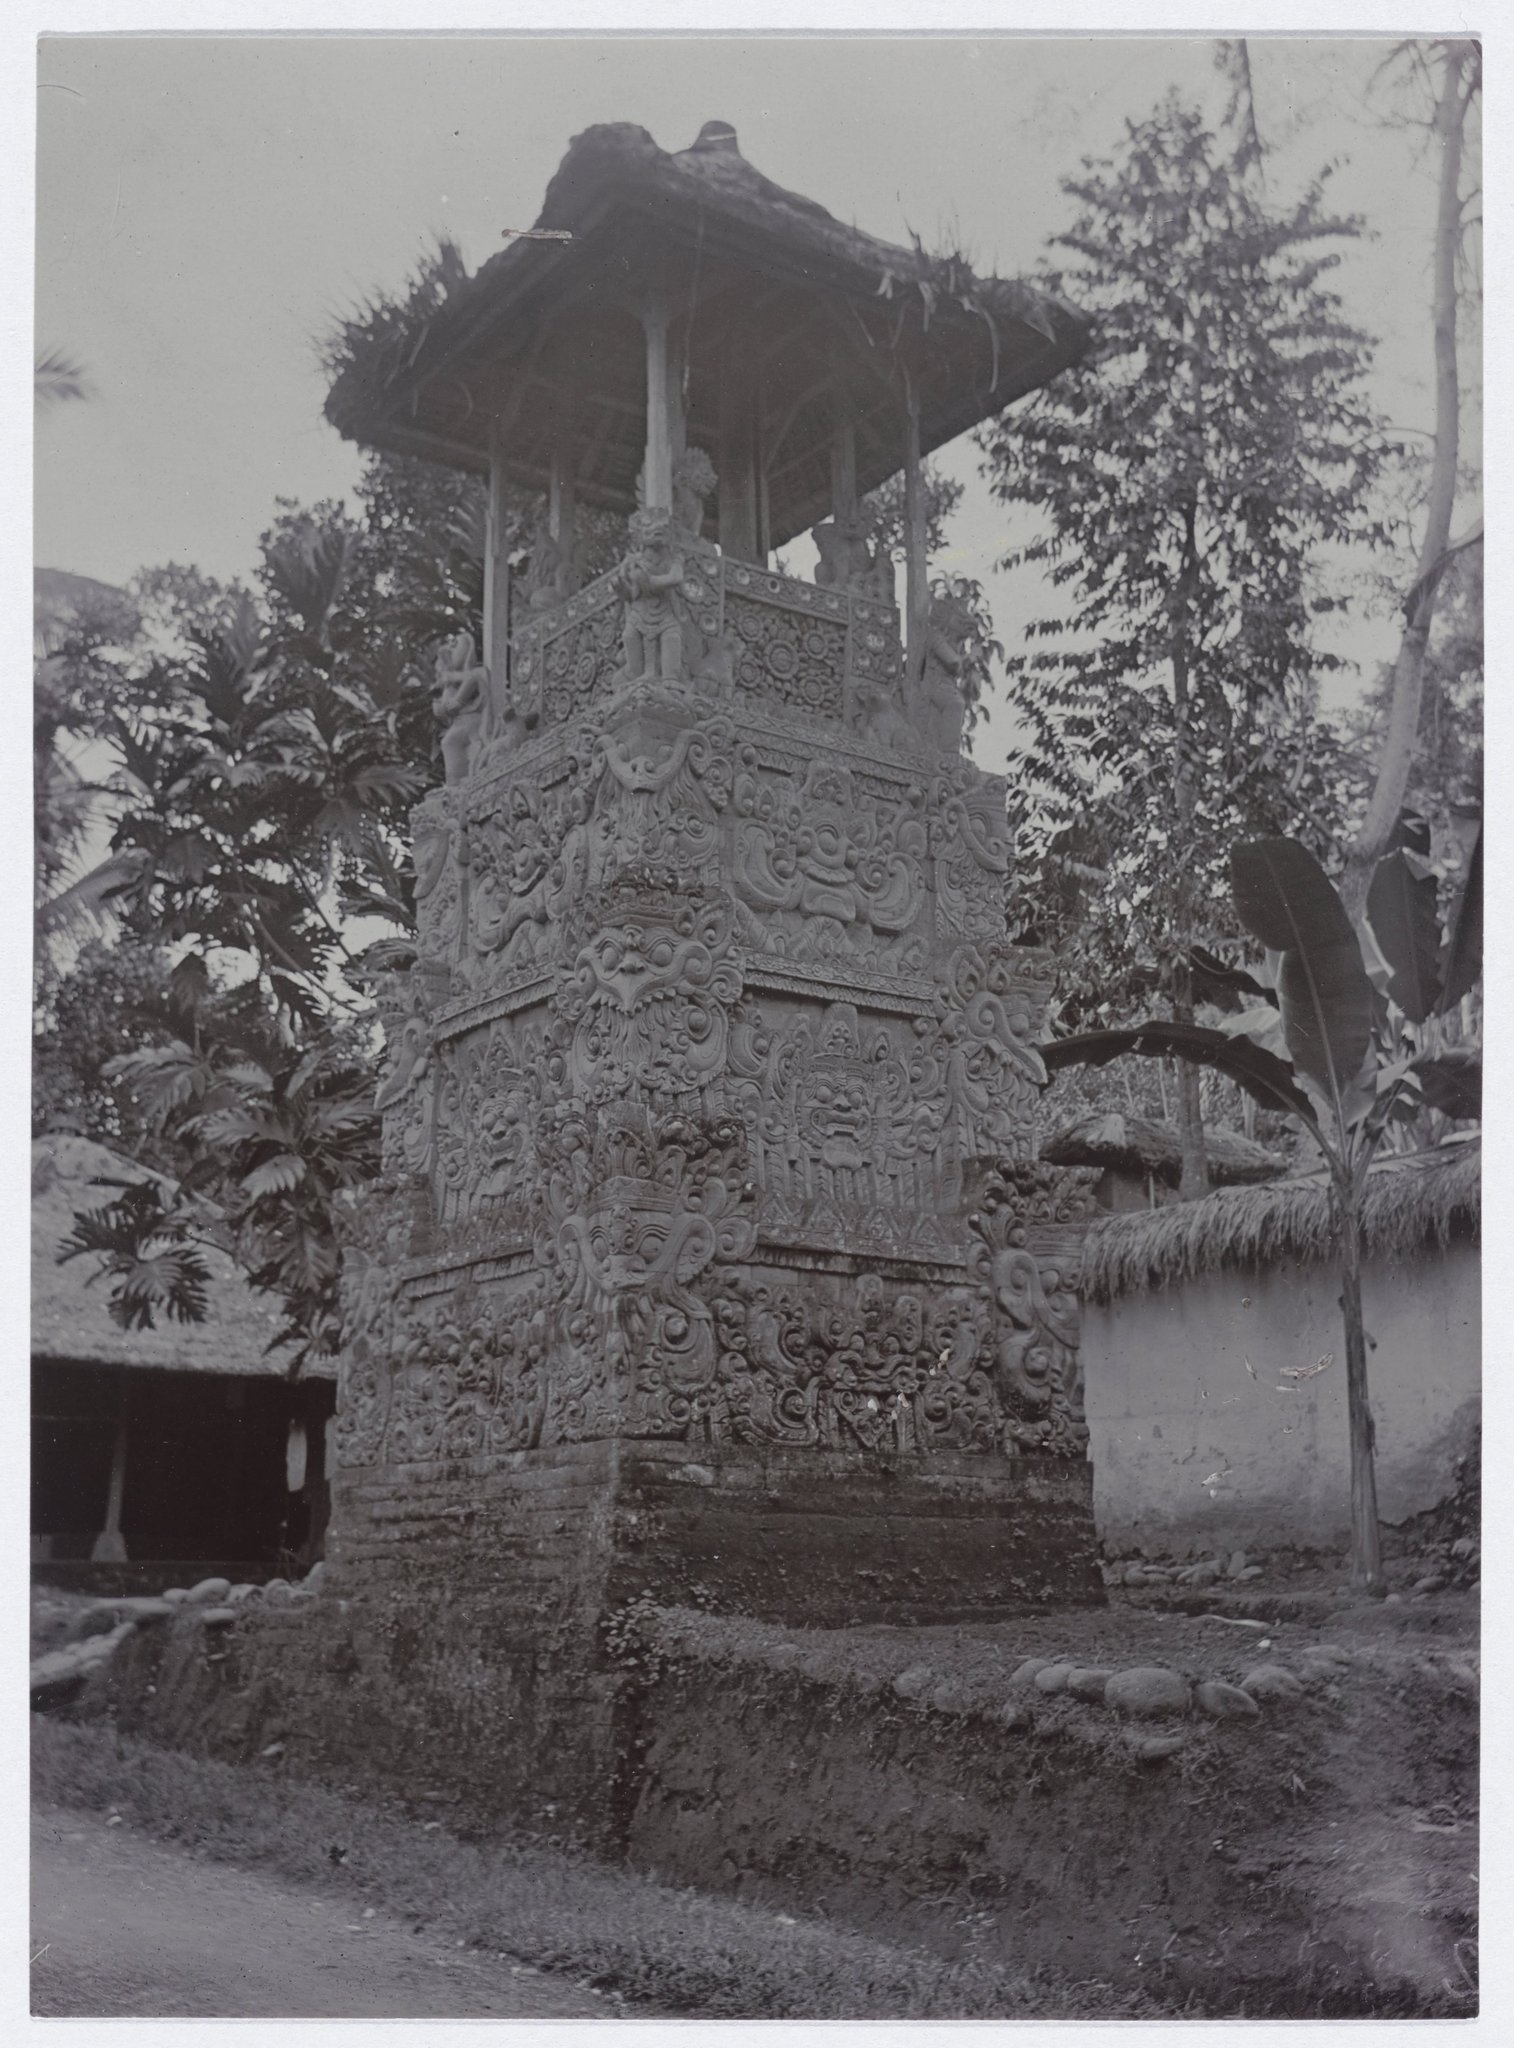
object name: photograph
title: 4. Zuid Bali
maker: johanna hermina marmelstein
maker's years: 1897-1990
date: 1900-1915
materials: paper, photographic support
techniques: albumen print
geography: jakarta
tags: bali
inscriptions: annotation: ‘4. Zuid Bali. Roemah koel-koel (met tongtong) te Blajoe tusschen Tabanan en Badoeng.’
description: Een gedecoreerde toren, alleen toegankelijk voor priesters, nabij een tempelcomplex.